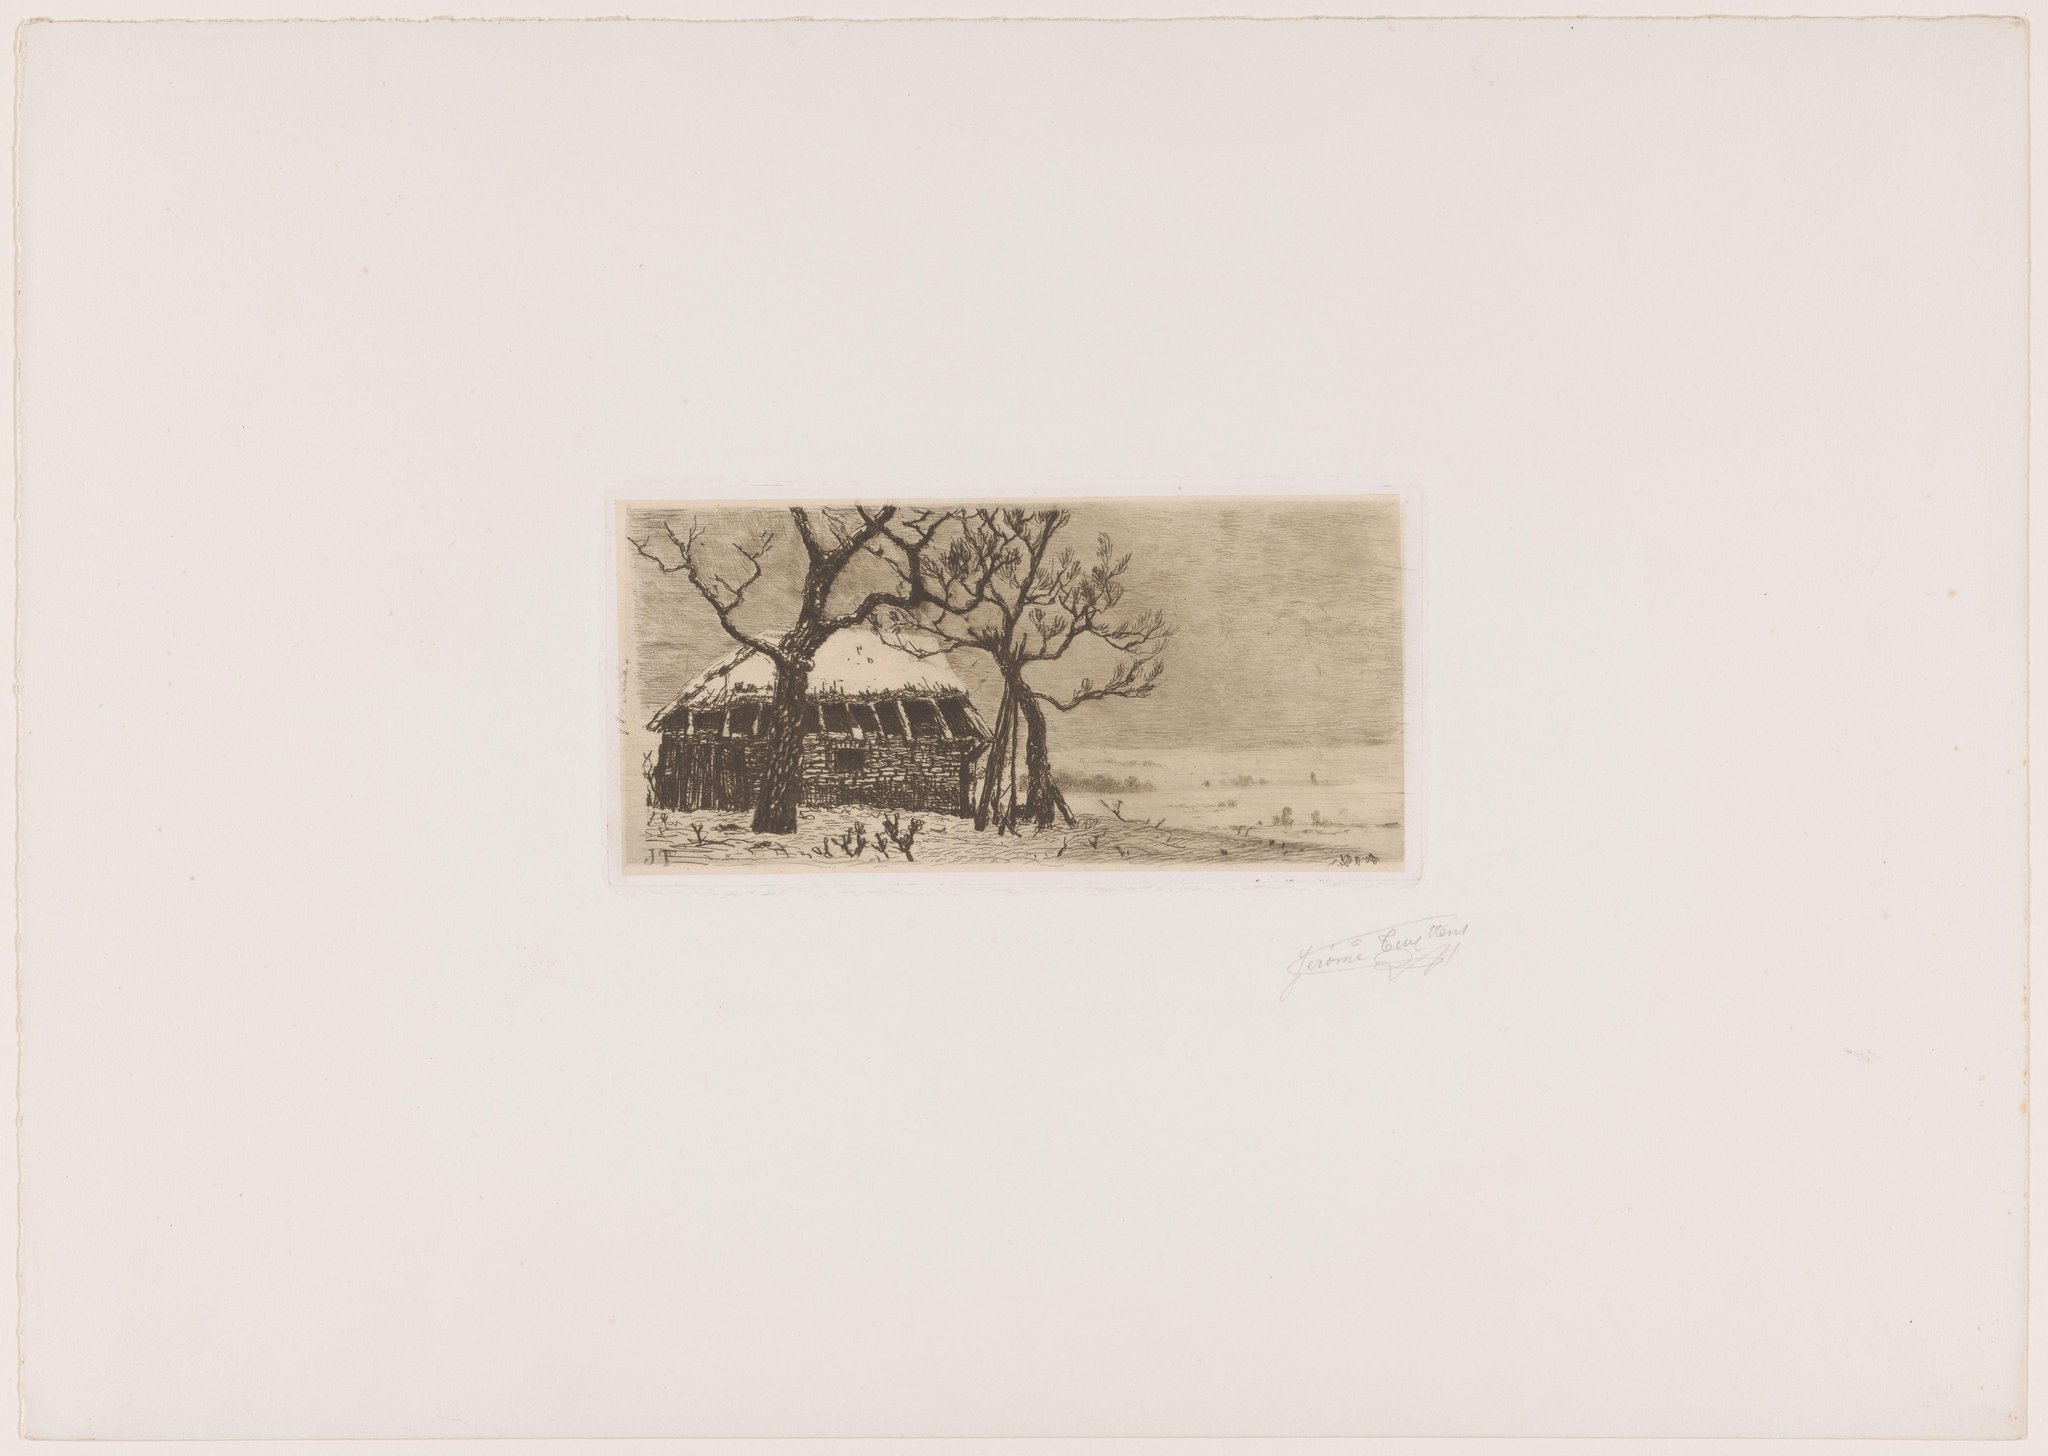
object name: print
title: Winterlandschap met hut bij twee bomen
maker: jerôme tuyttens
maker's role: painter, print maker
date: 1850-1883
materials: paper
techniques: drypoint, etching, intaglio, retroussage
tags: snow, hut, cabin, lodge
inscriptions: collector's mark: Lugt 2228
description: Sterfdatum van de prentmaker is onbekend. Daarom is voor de bepaling van de rechten van dit object gebruik gemaakt van de verwervingsdatum Rijksmuseum Amsterdam.